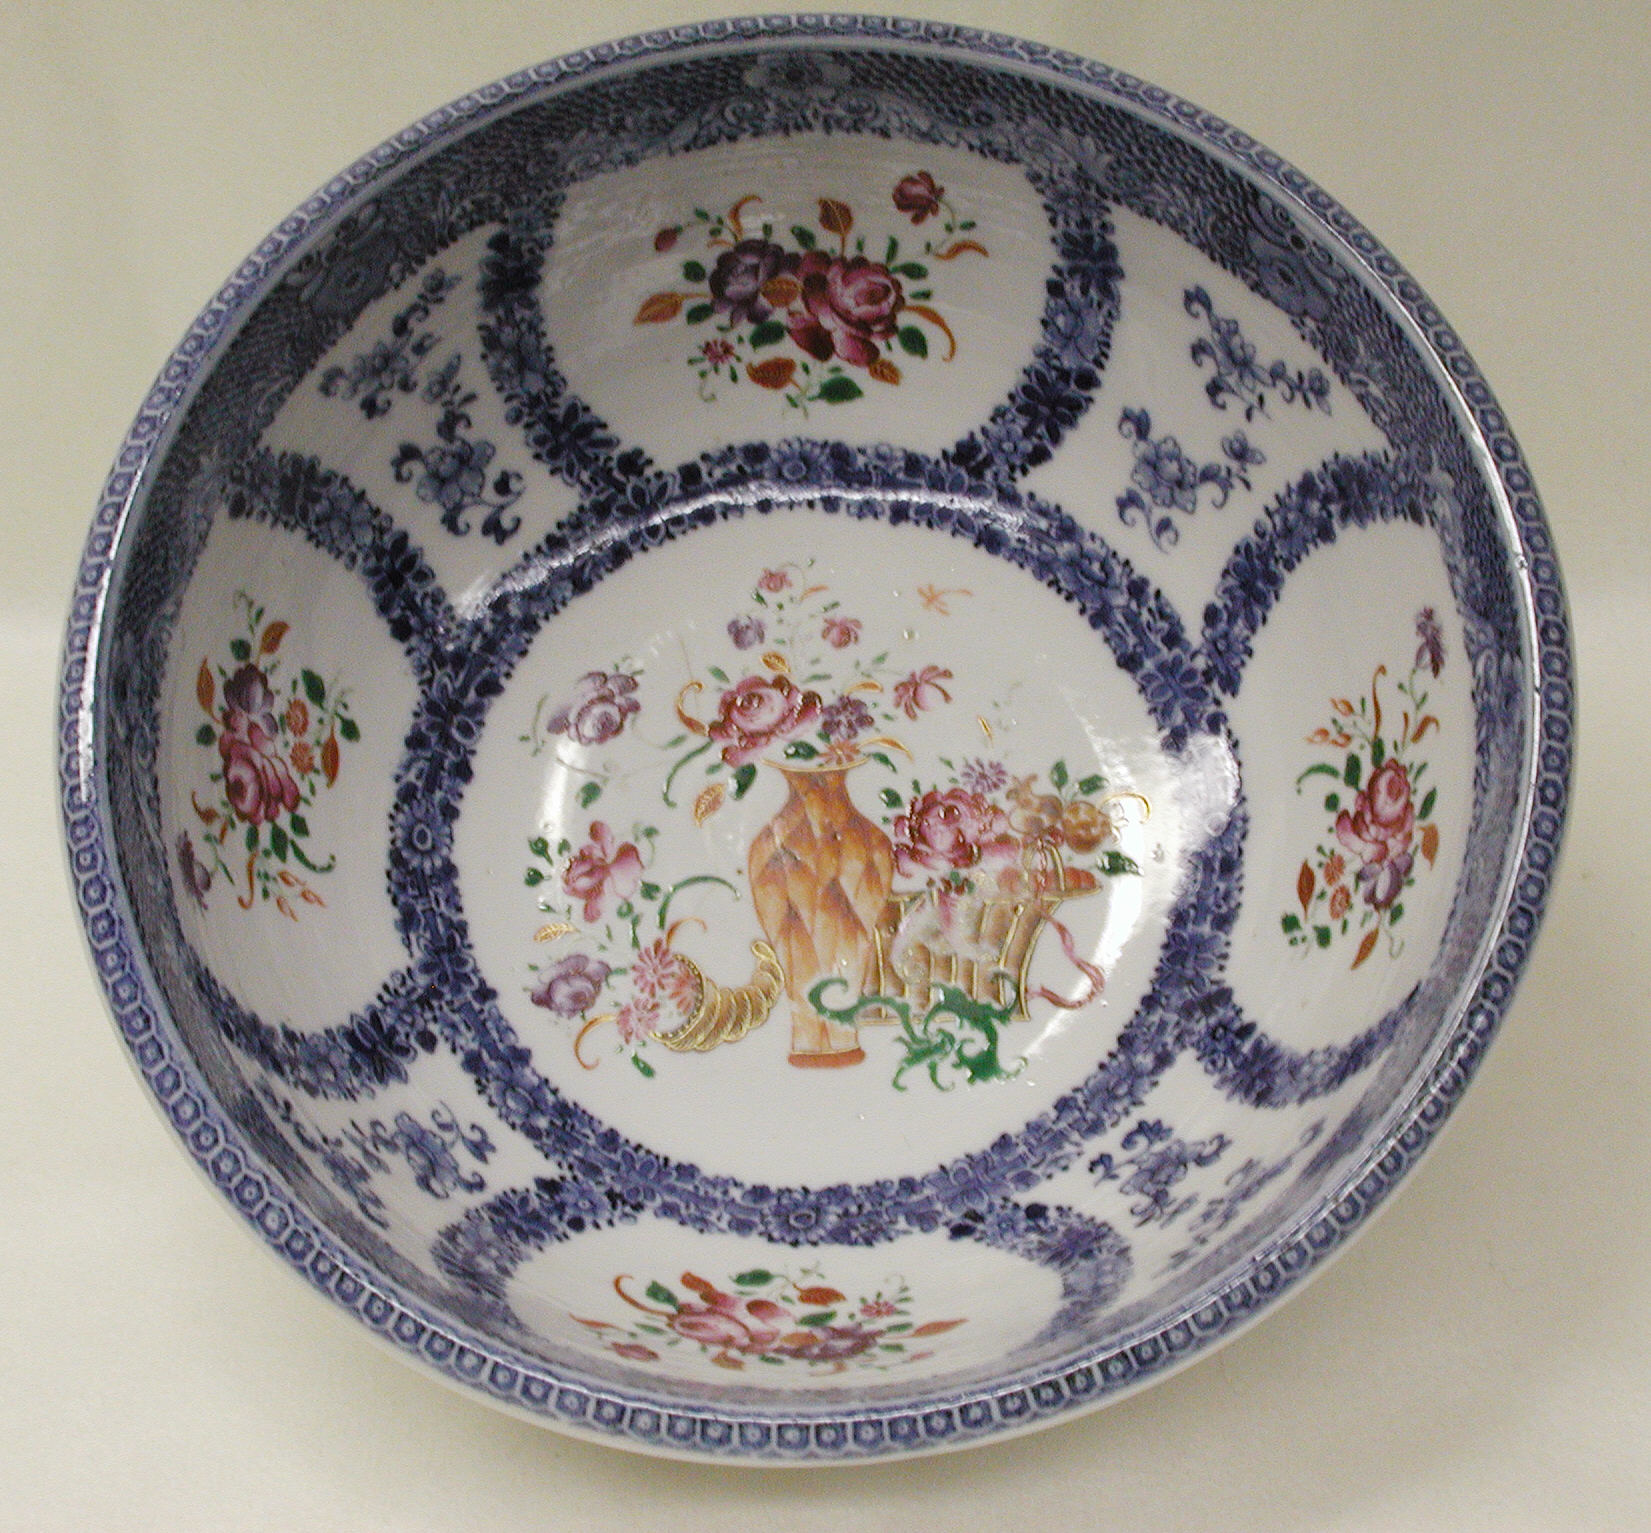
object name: basin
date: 1765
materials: hard paste porcelain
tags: flowers,leaves